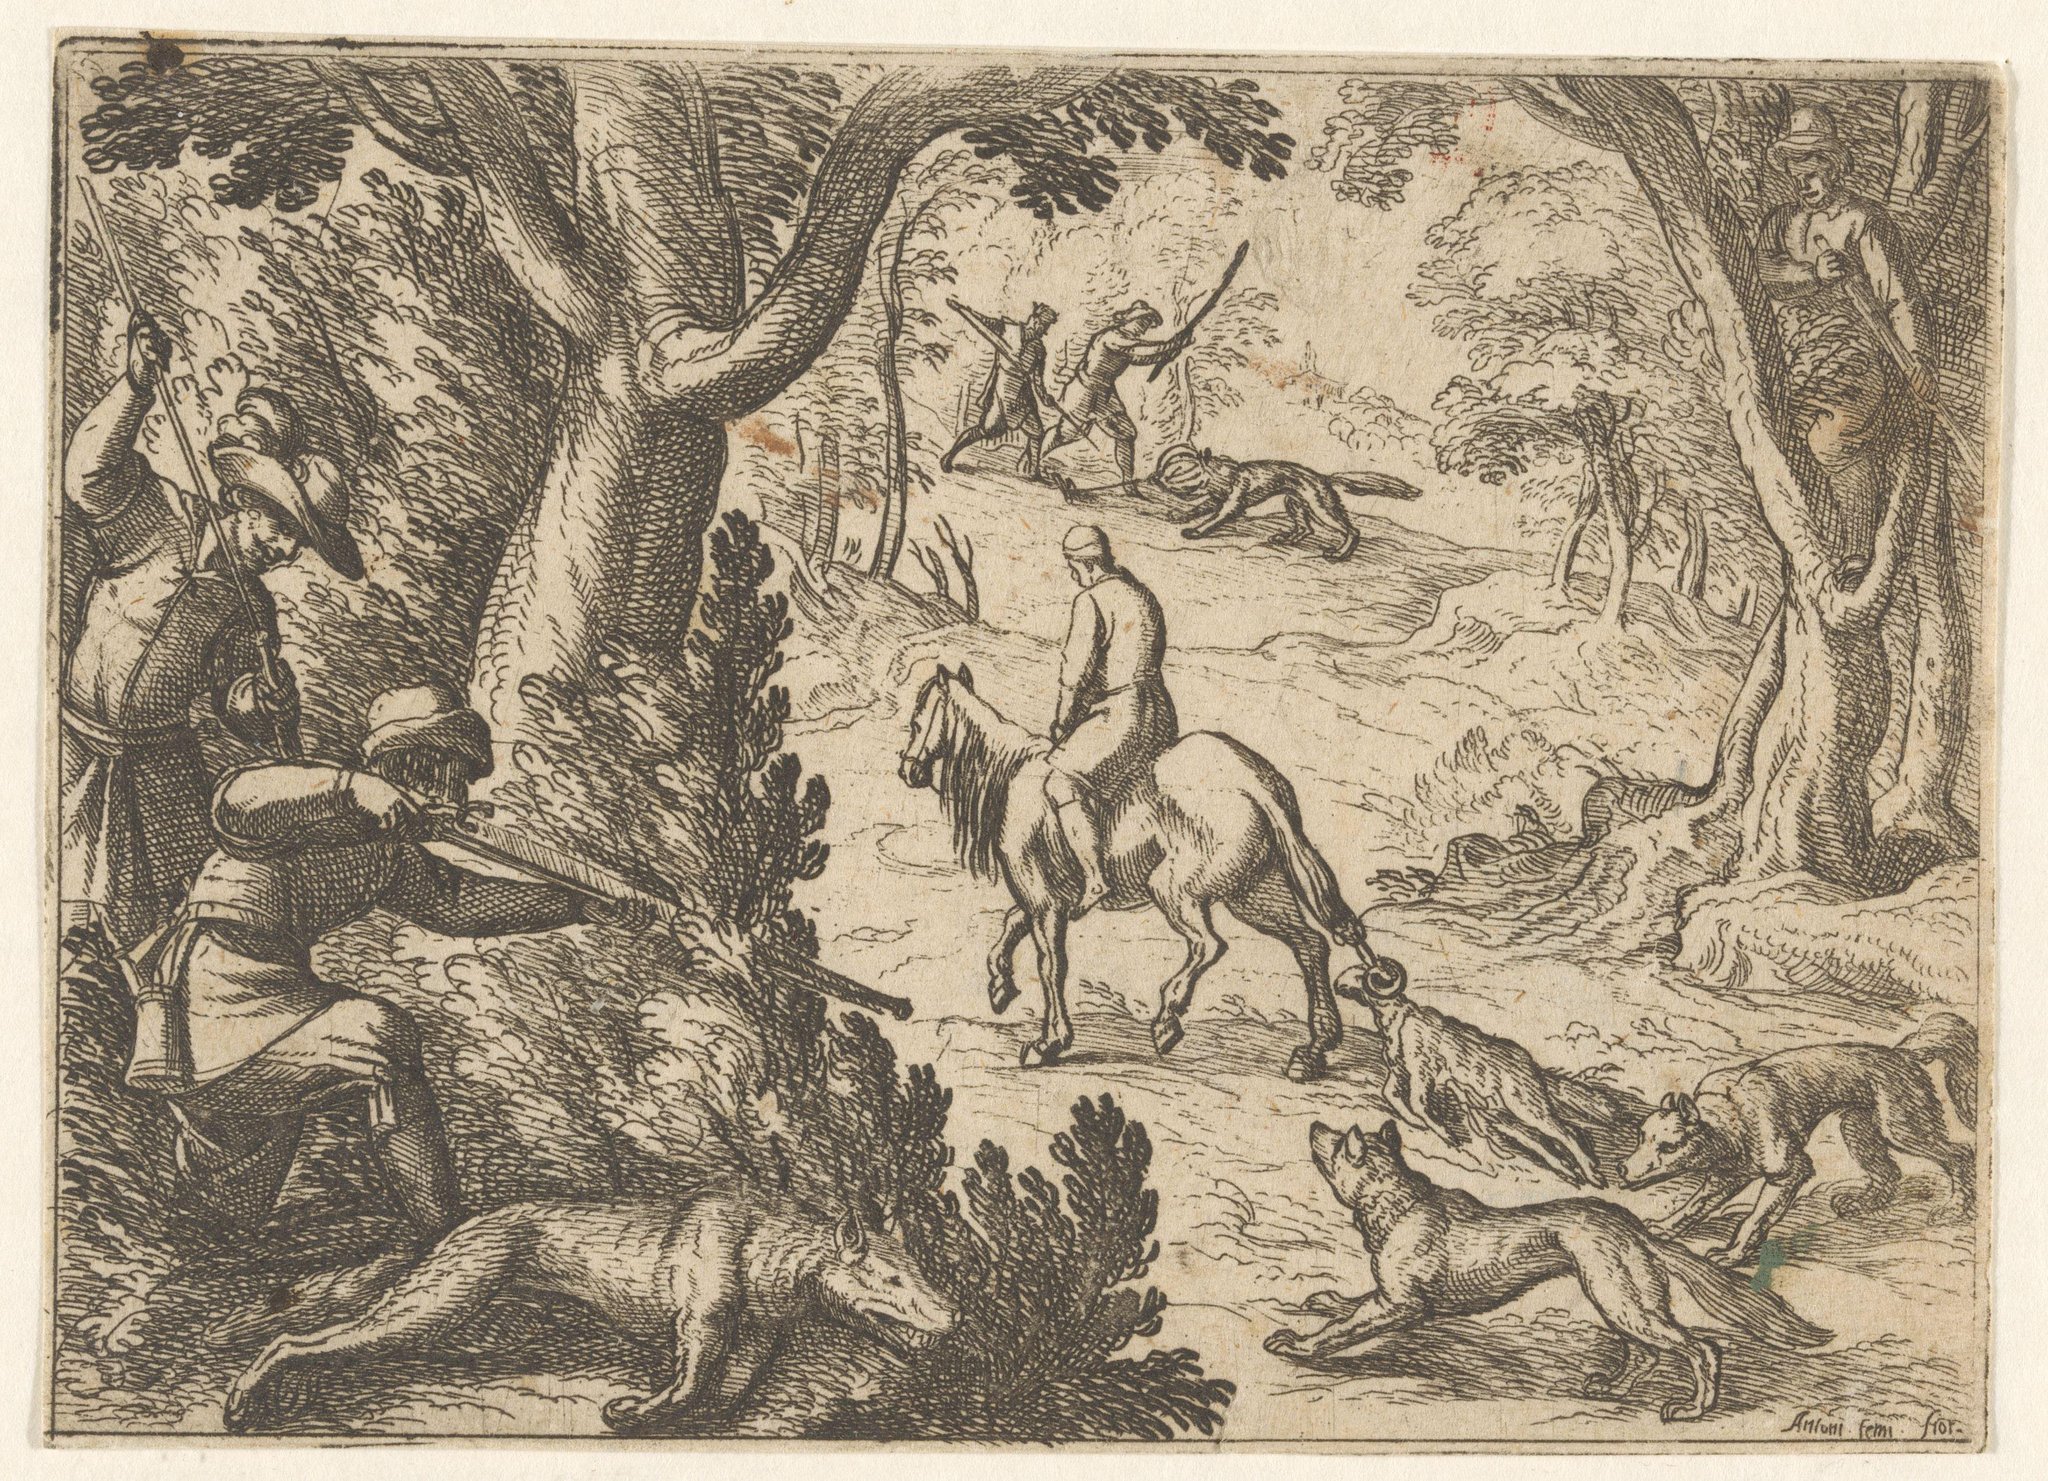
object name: print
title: Primo libro di caccie varie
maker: antonio tempesta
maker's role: draughtsman, painter, print maker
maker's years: 1555-1630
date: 1598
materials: paper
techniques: etching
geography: italy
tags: hunter, hunters hunting (n.b.: in 1988-1990 this notation denoted the concept of 43c11421 'hunters resting during the hunt'), hunt ~ mammals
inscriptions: collector's mark: Lugt 2228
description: Een man te paard trekt een dode ram door het bos. Het dode ram trekt wolven aan. Vanachter bomen en struiken richten jagers hun geweren op de wolven. Anderen steken de wolven met speren.